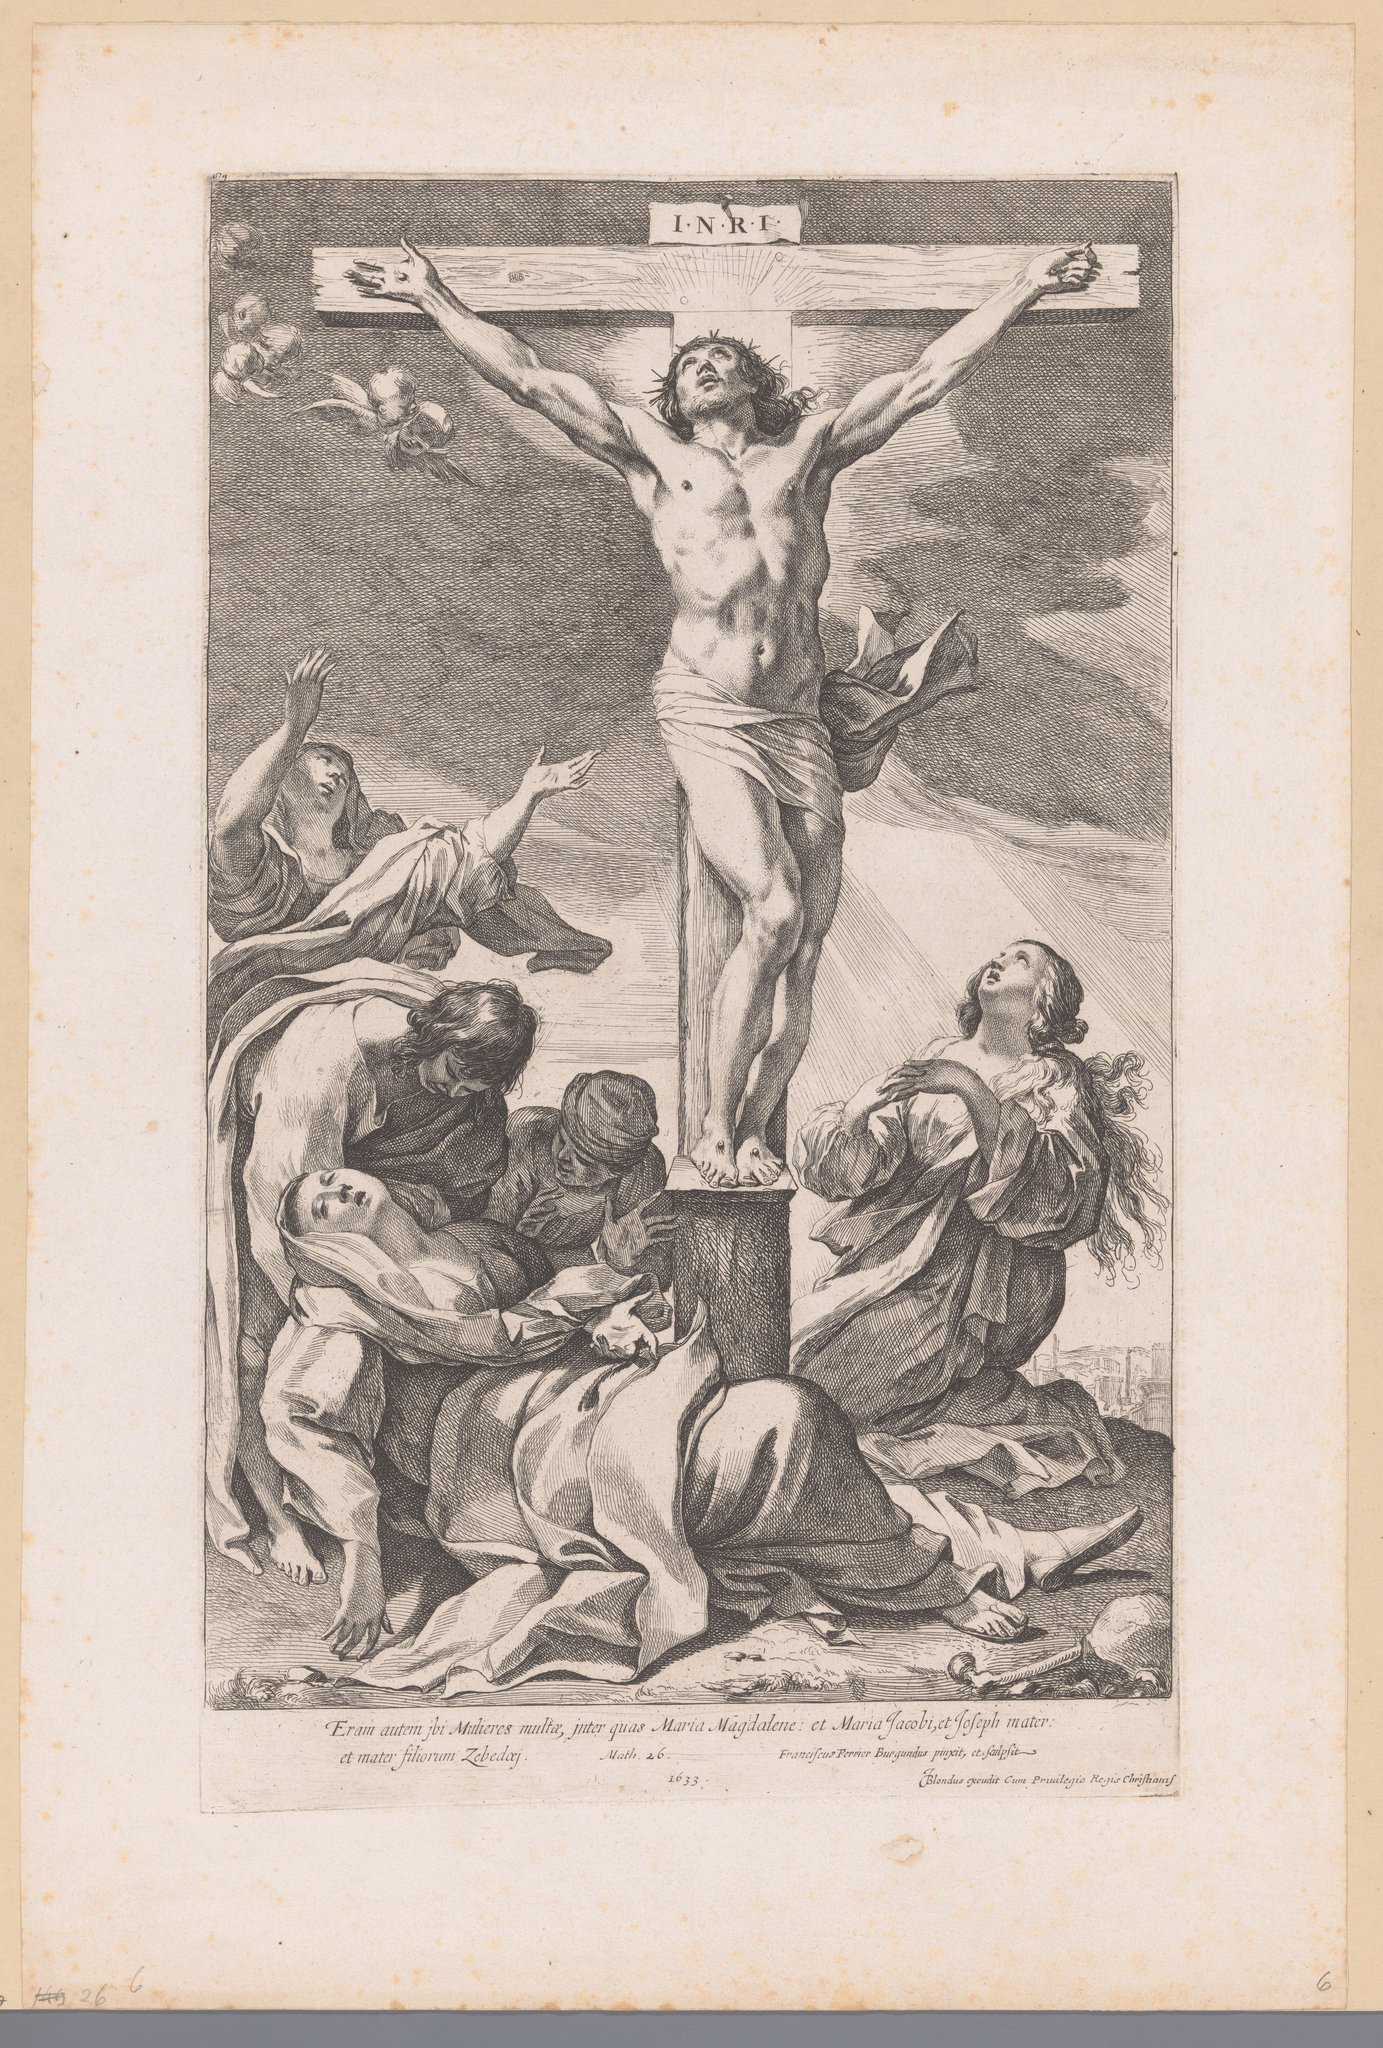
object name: print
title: Christus aan het kruis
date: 1633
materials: paper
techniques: etching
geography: france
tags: the crucifixion of christ: christ's death on the cross; golgotha (matthew 27:45-58; mark 15:33-45; luke 23:44-52; john 19:25-38)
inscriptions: collector's mark: Lugt 240